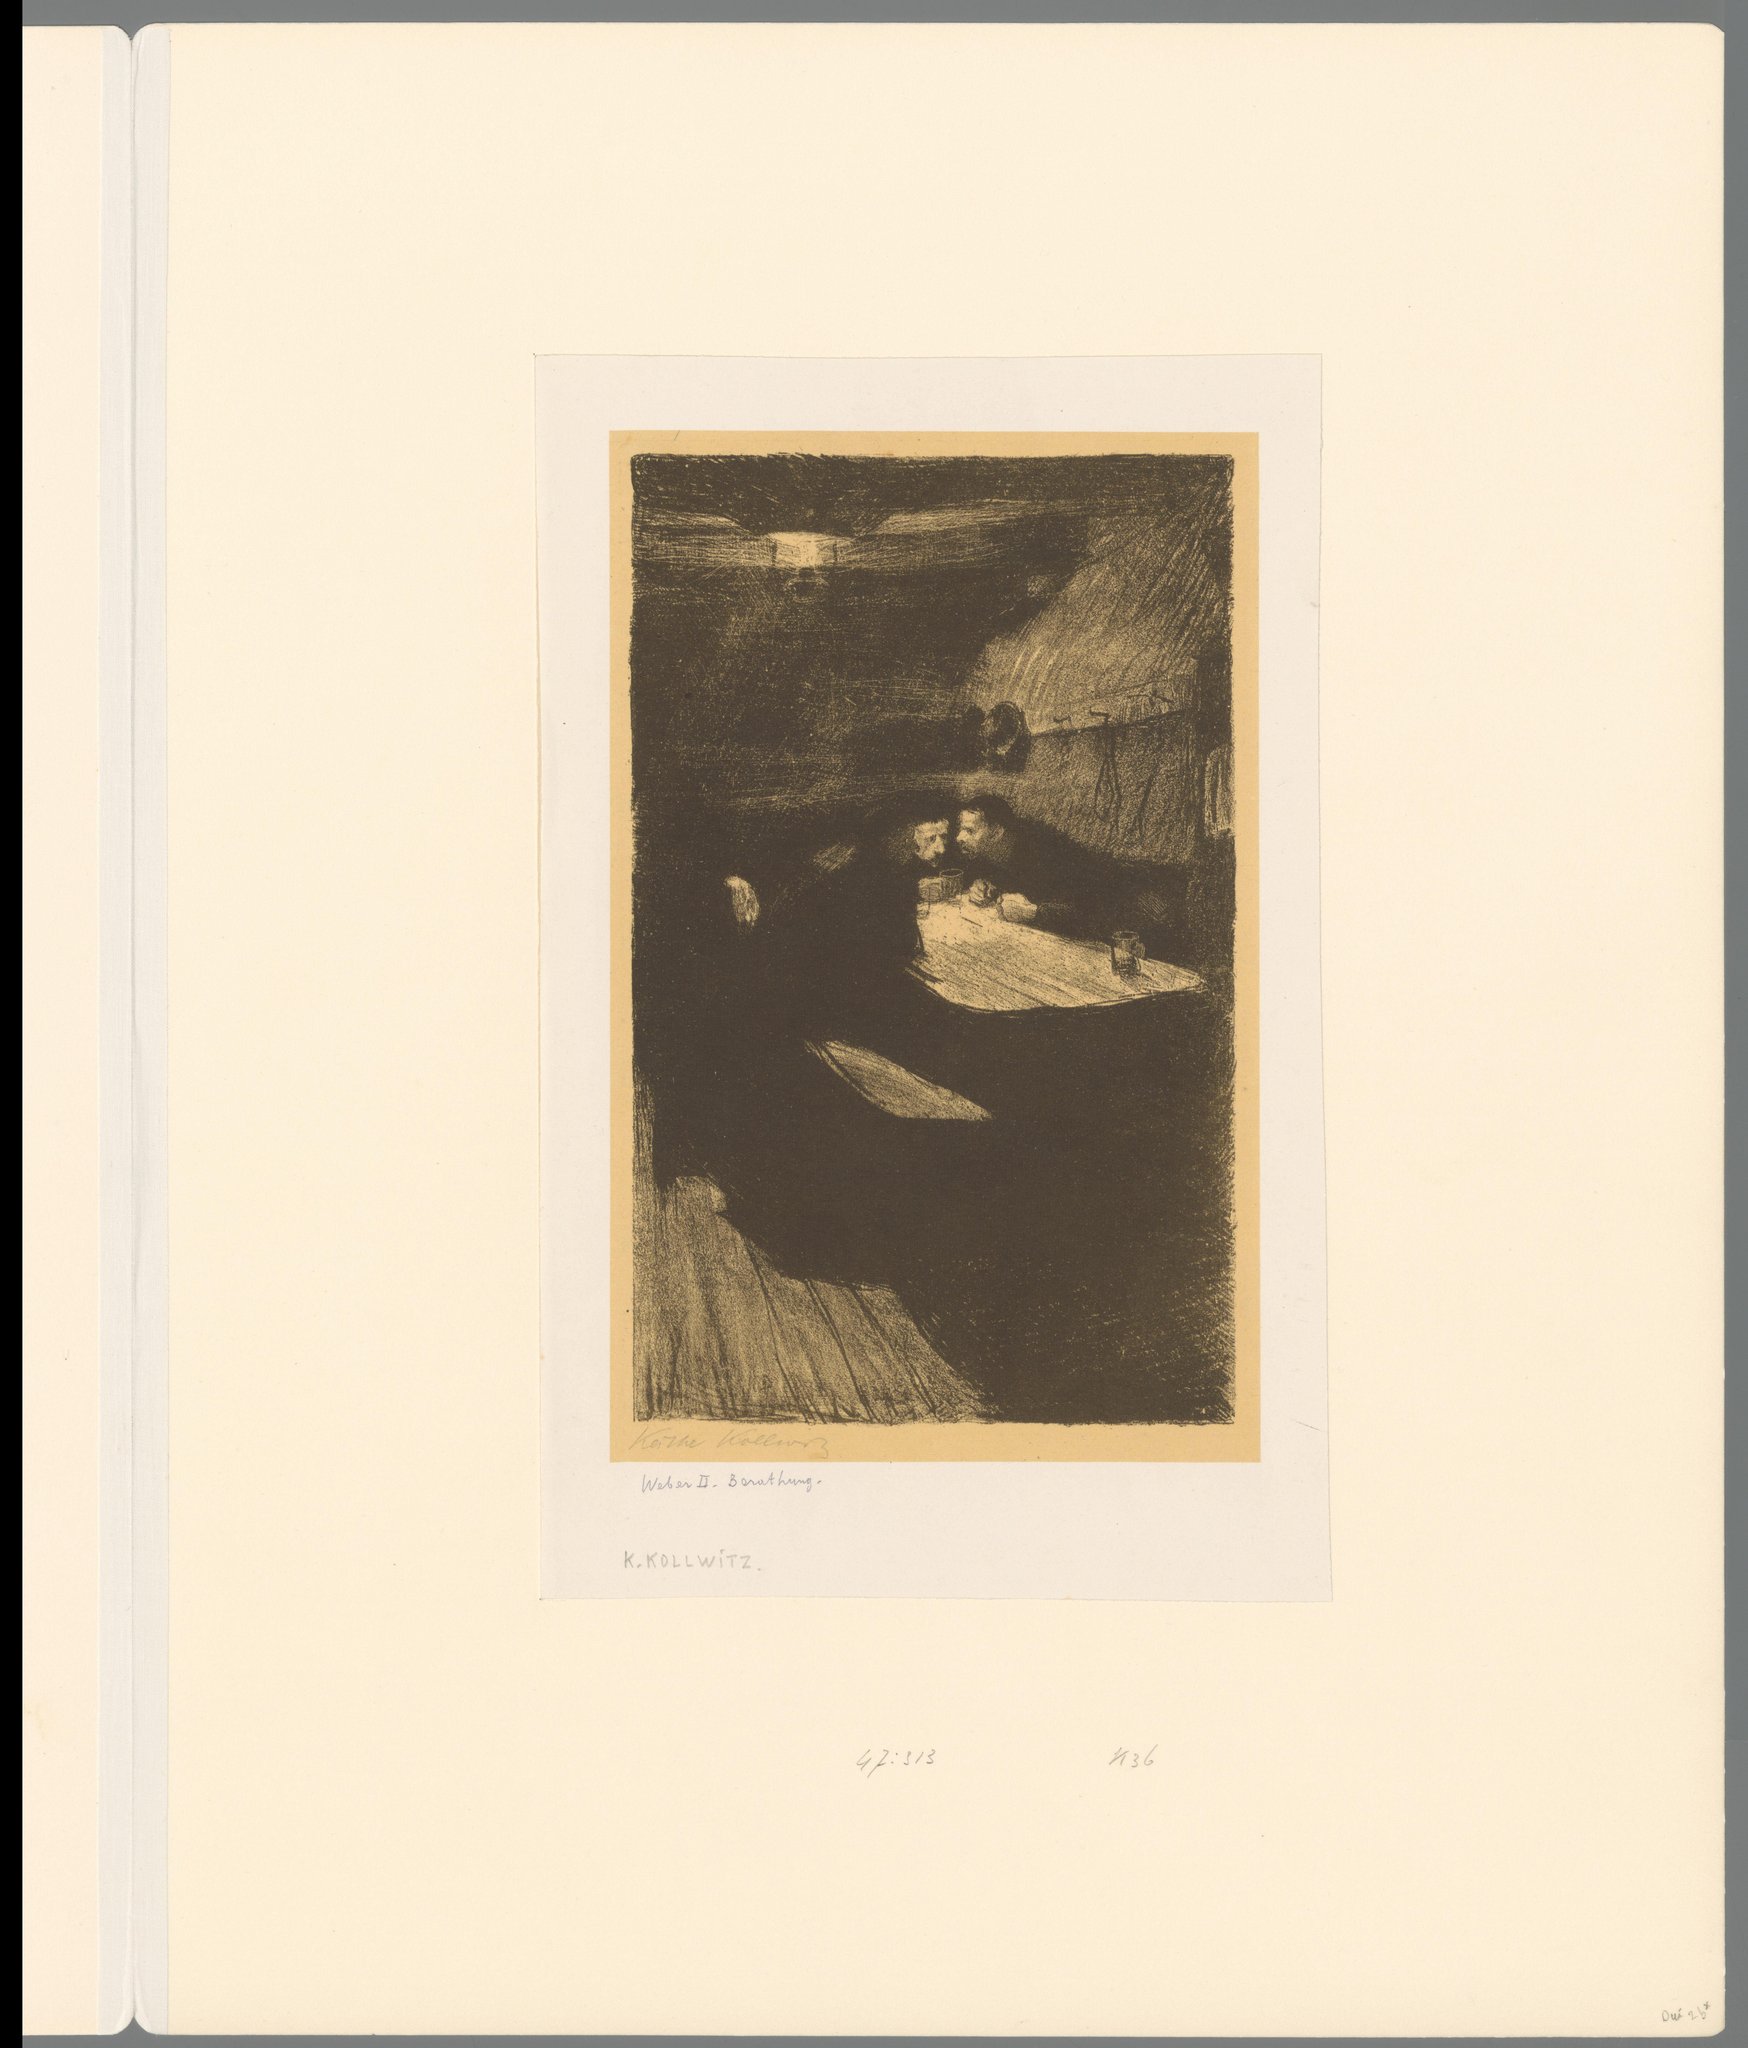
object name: print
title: Ein Weberaufstand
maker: käthe kollwitz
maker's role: draughtsman, print maker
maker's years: 1867-1945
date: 1898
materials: paper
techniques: lithograph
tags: sitting figure, table, interior of the house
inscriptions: collector's mark: Lugt 2228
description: Deze prent is het derde blad uit de serie 'Ein Weberaufstand'.